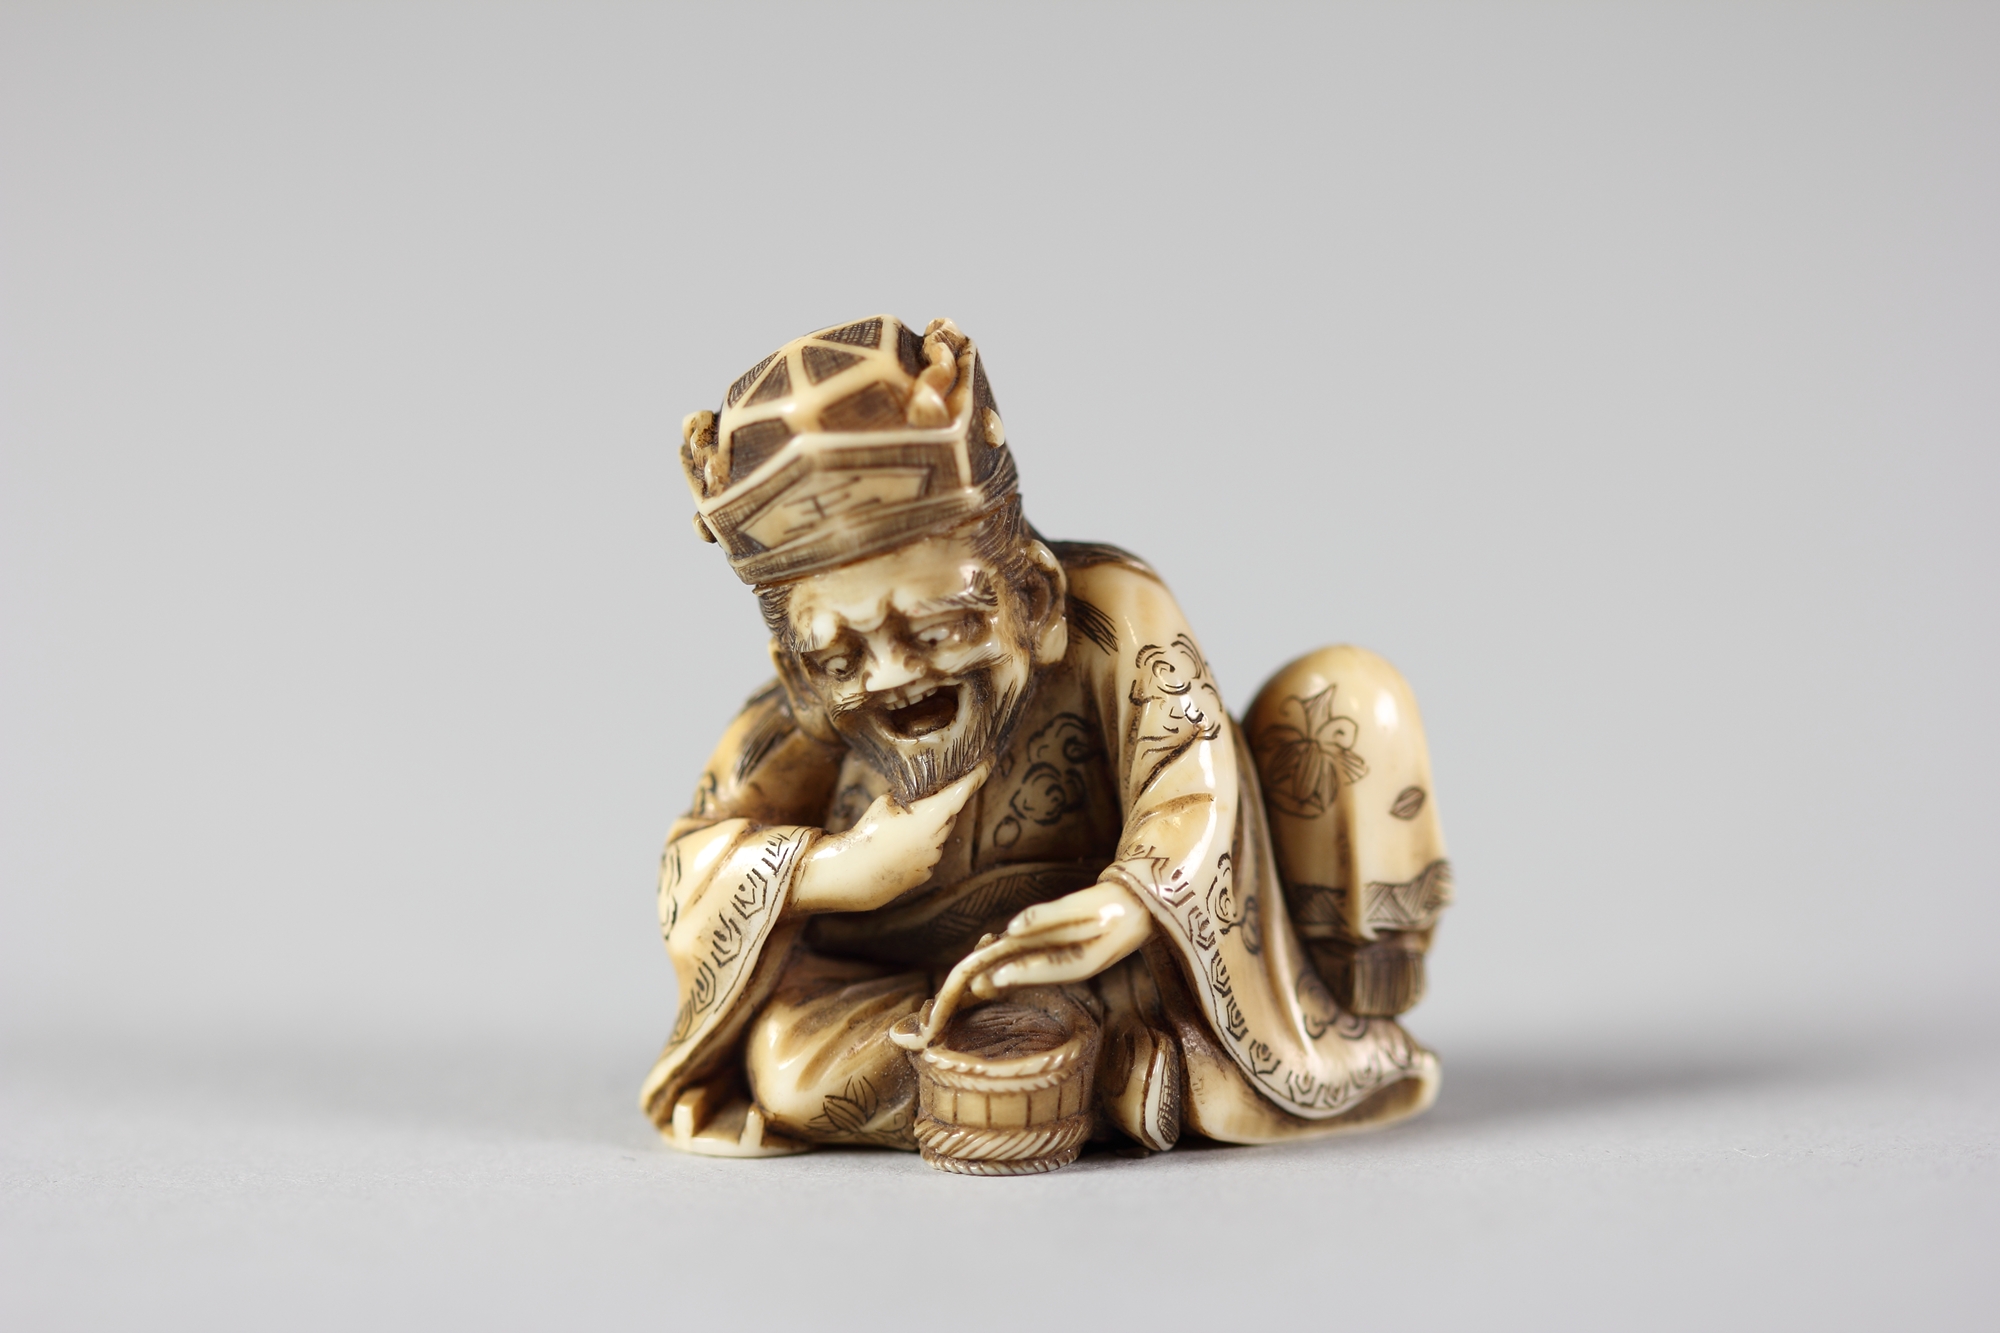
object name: netsuke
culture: japanese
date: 1801-1900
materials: ivory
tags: men